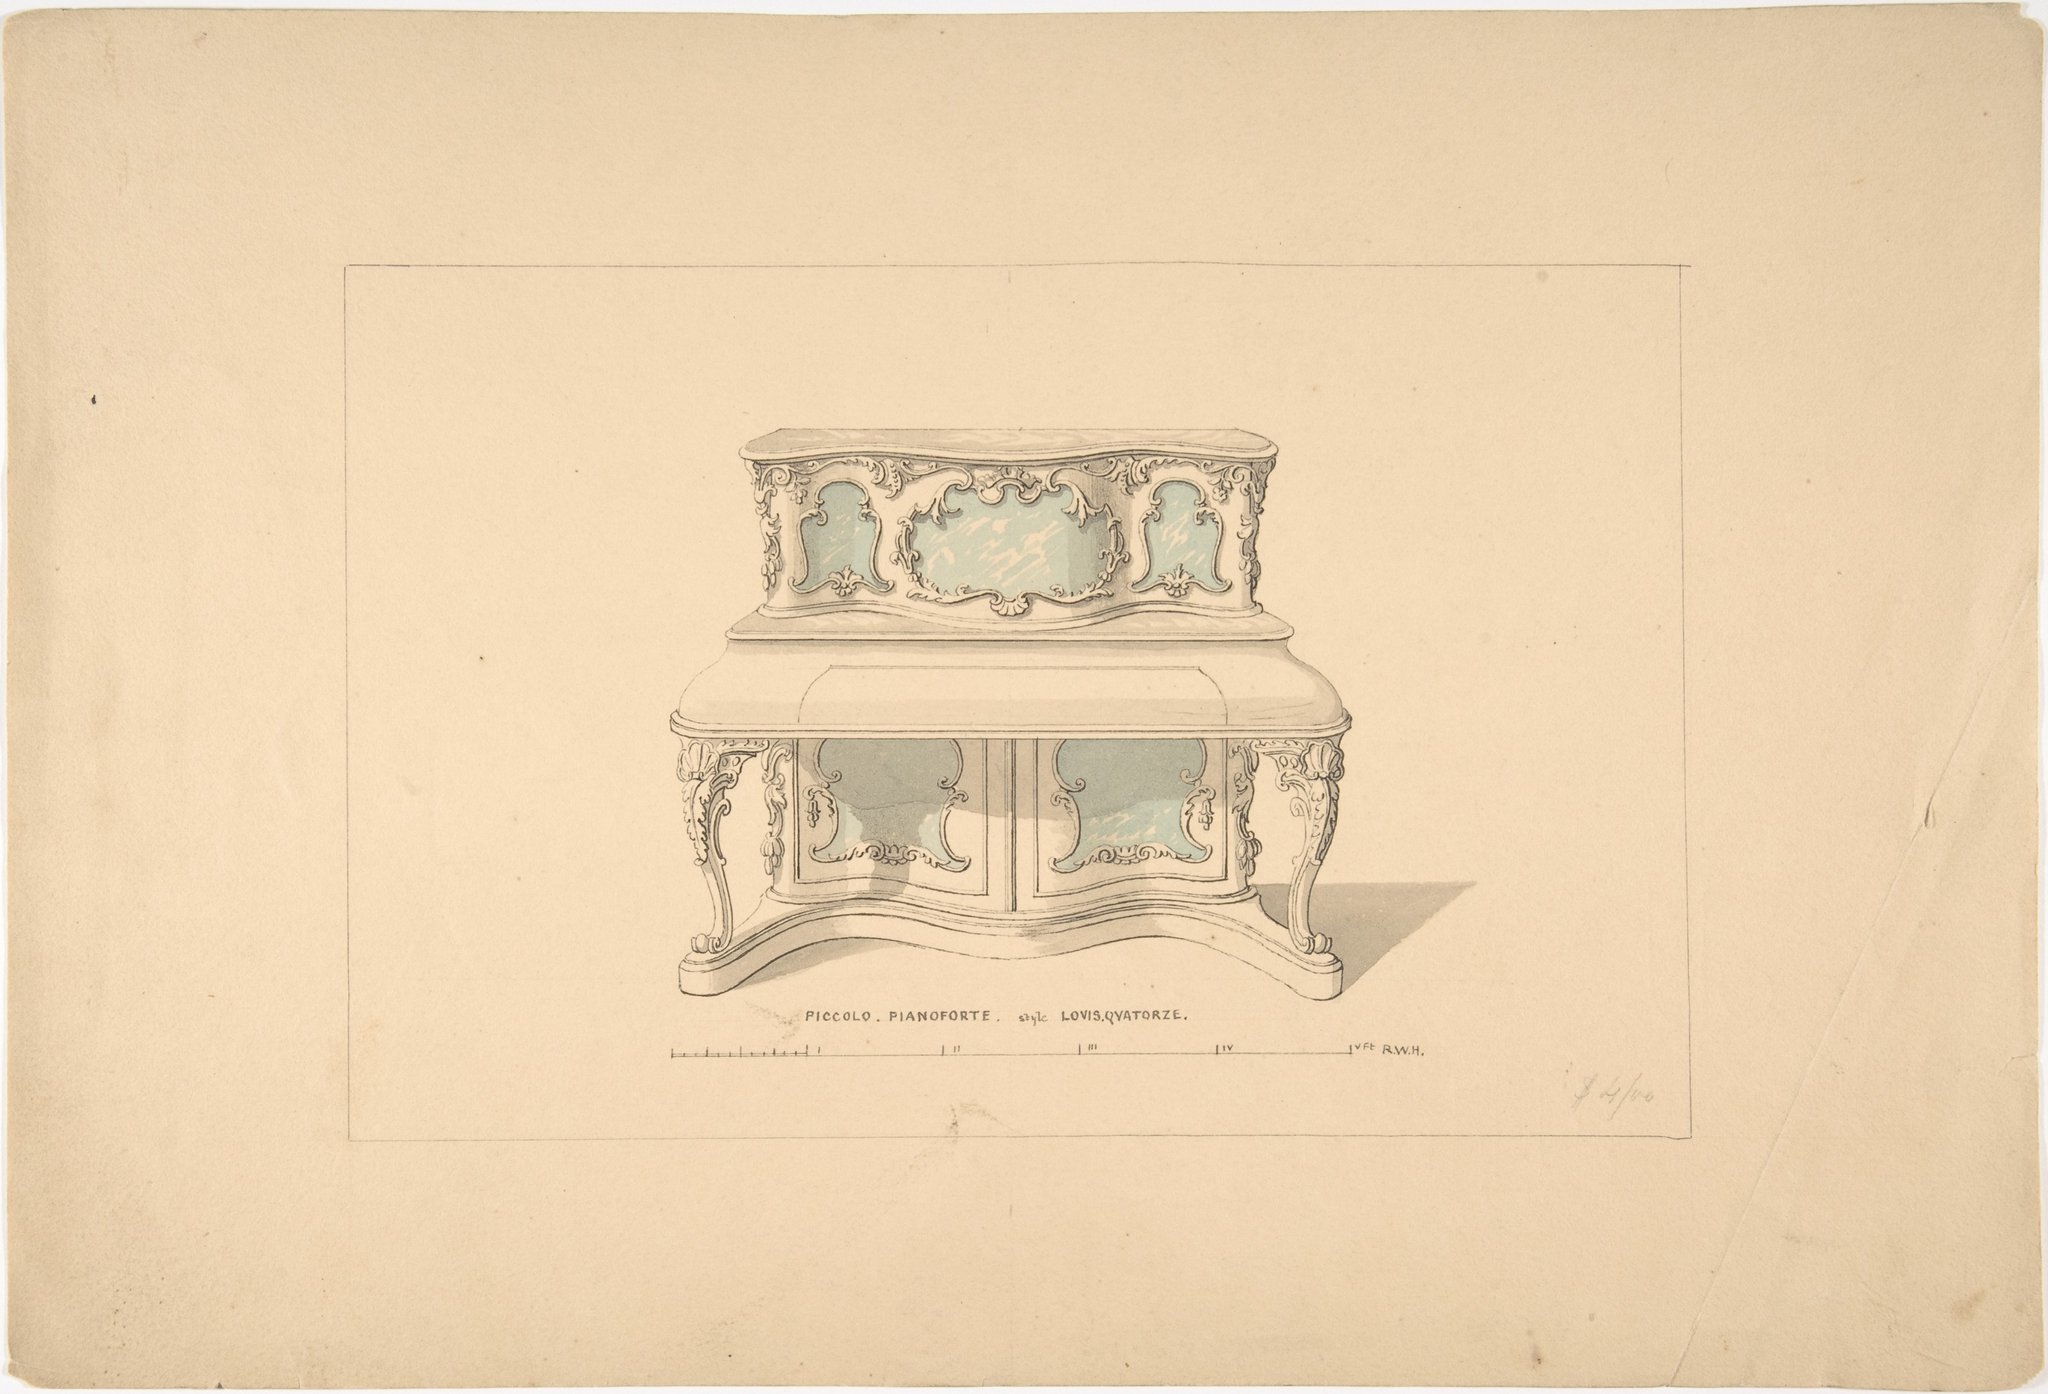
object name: drawing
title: Design for Piccolo Pianoforte, Louis Quatorze Style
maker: robert william hume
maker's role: artist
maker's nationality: british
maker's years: 1816-1904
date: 1835-1900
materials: graphite, ink, watercolor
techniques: pen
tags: pianos